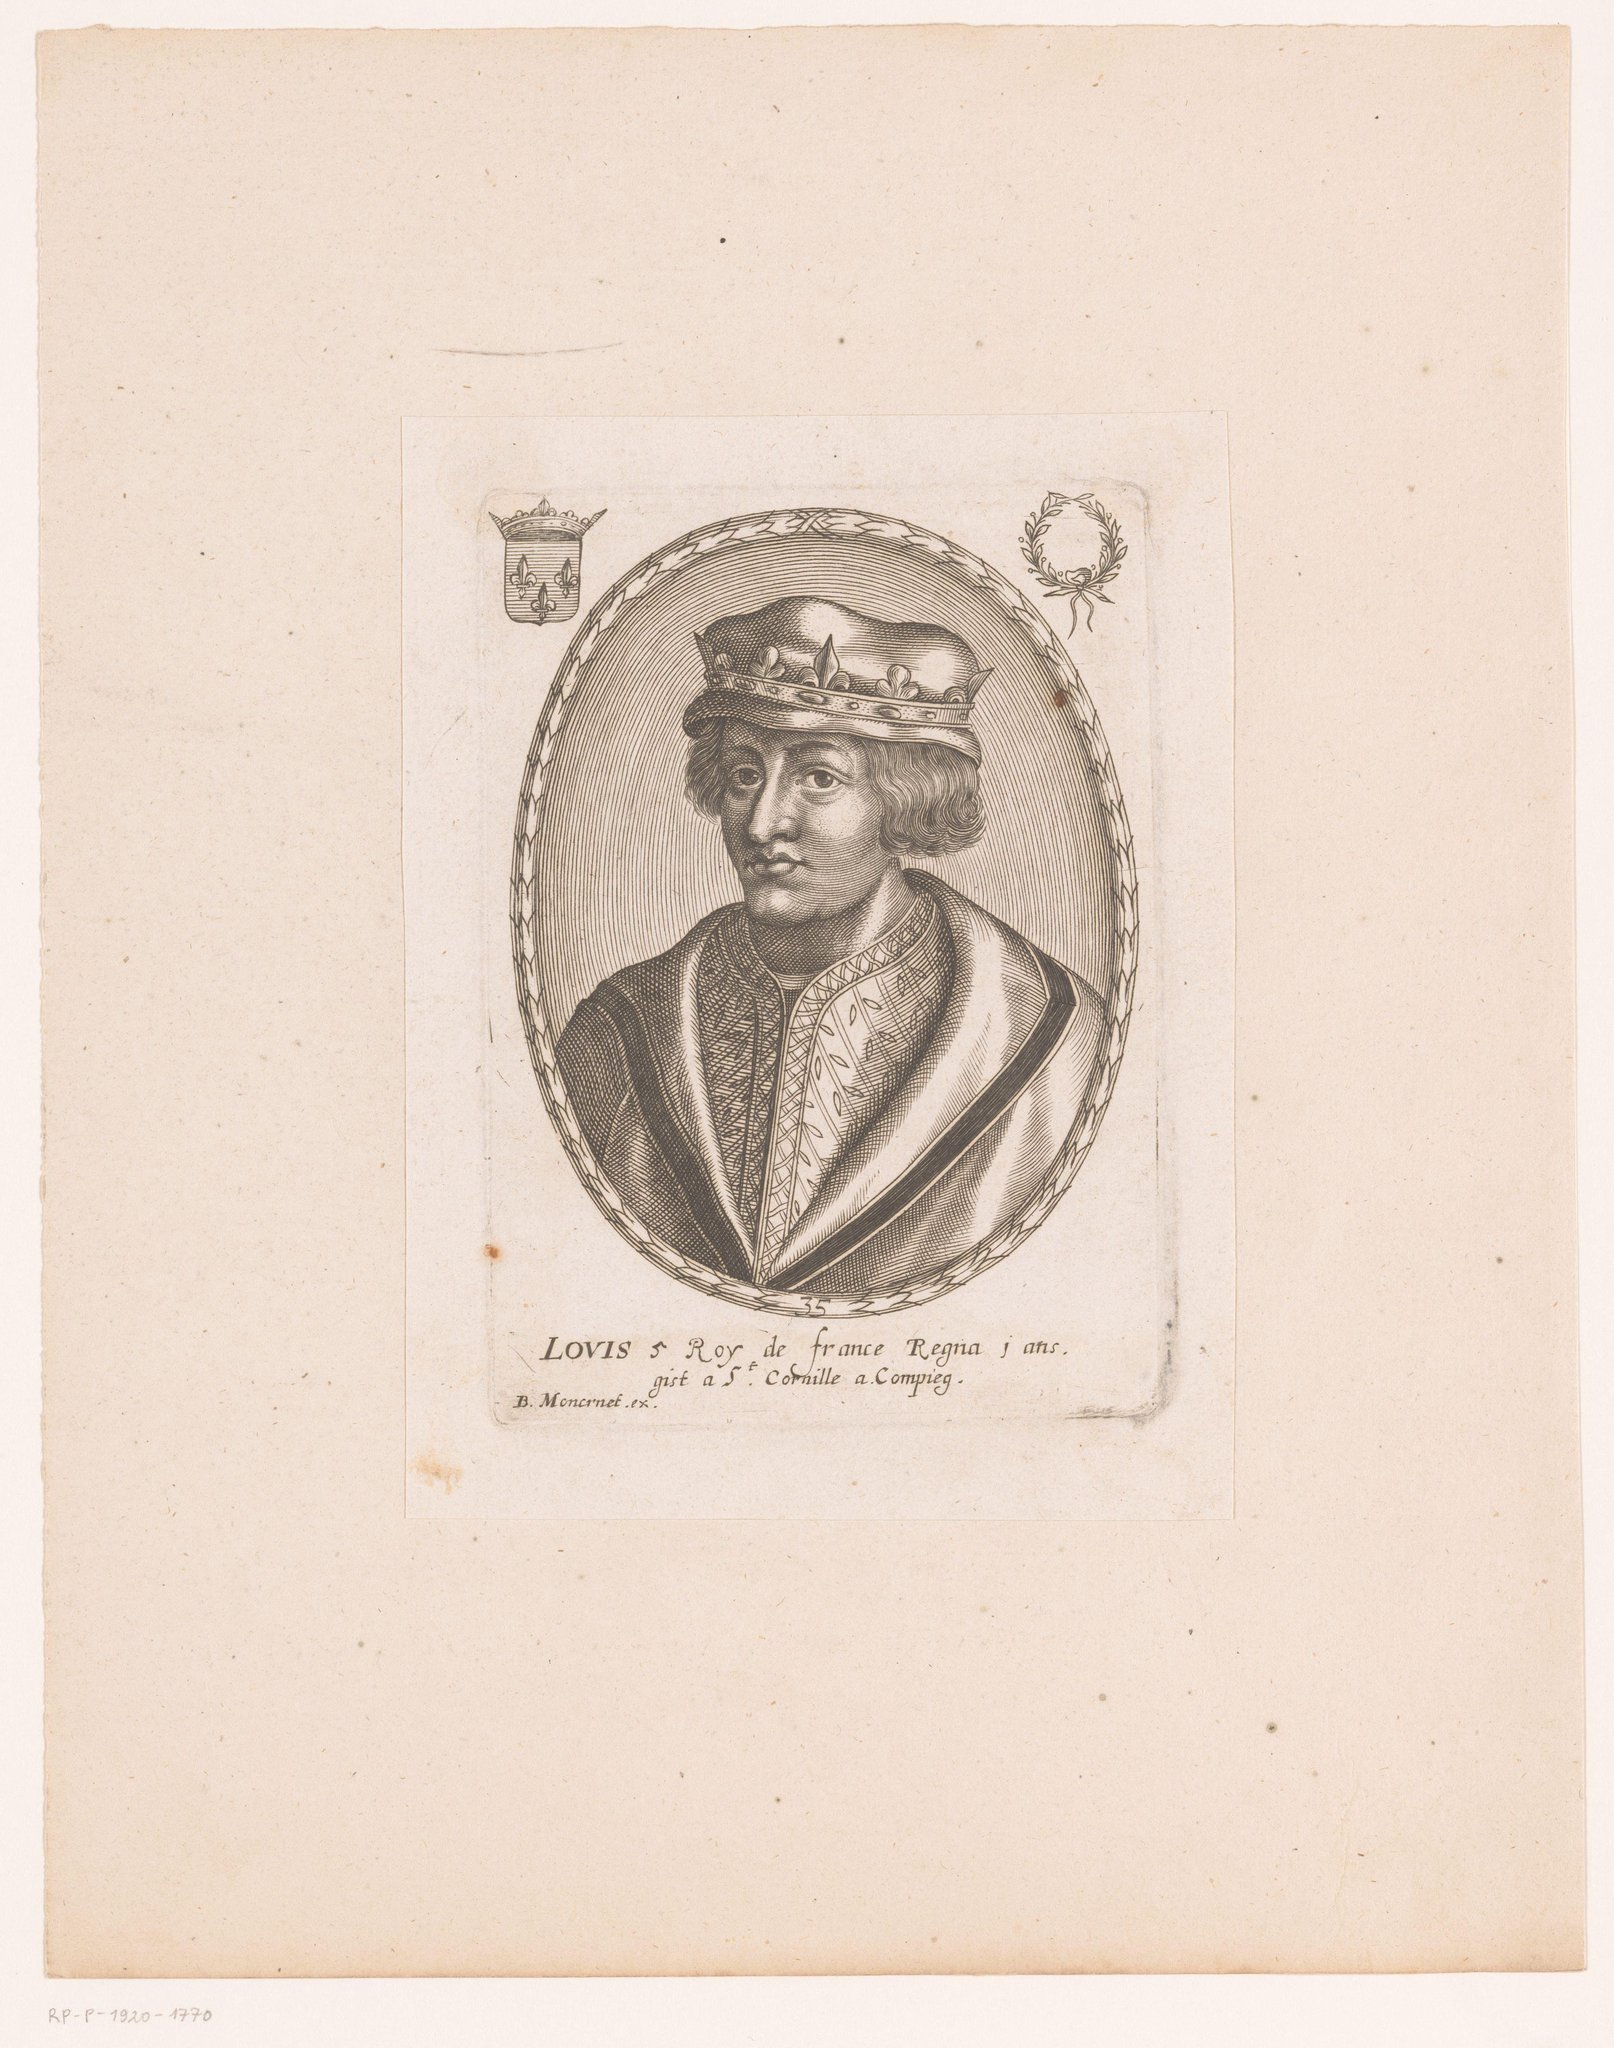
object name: print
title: Portret van Lodewijk V van Frankrijk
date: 1610-1668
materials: paper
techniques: engraving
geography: paris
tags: historical persons, king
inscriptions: collector's mark: Lugt 2228